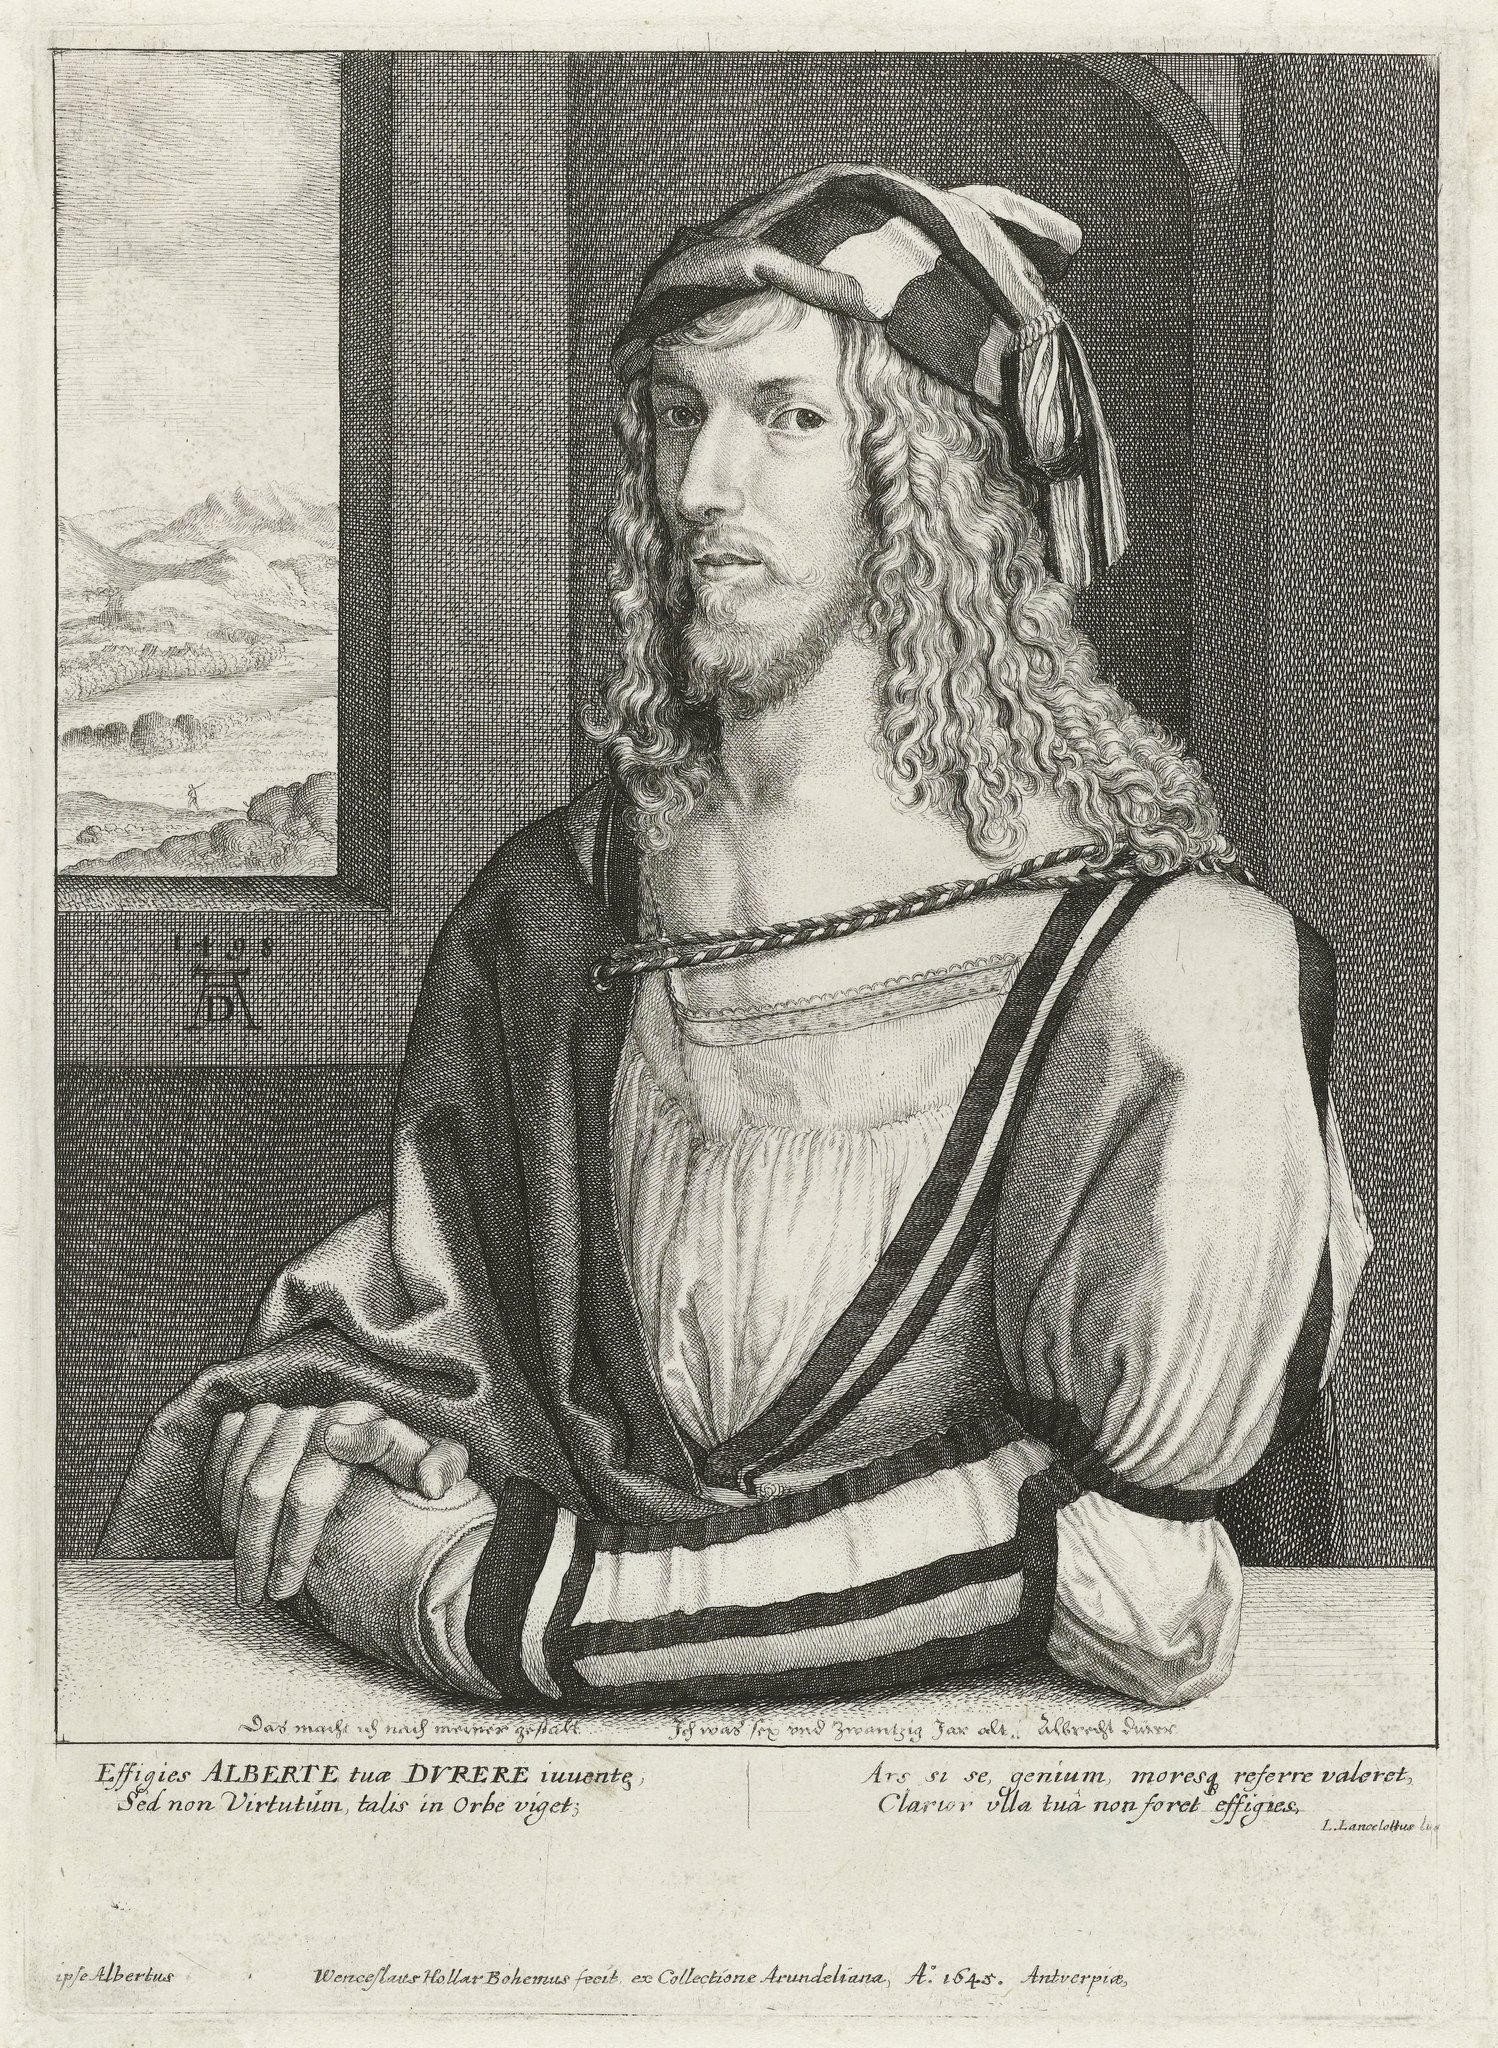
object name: print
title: Portret van Albrecht Dürer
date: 1645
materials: paper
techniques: etching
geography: antwerp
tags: painter, print maker, draughtsman, albrecht dürer, styles of hairdress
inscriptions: collector's mark: Lugt 240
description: Portret van de Duitse kunstenaar Albrecht Dürer op 26-jarige leeftijd.